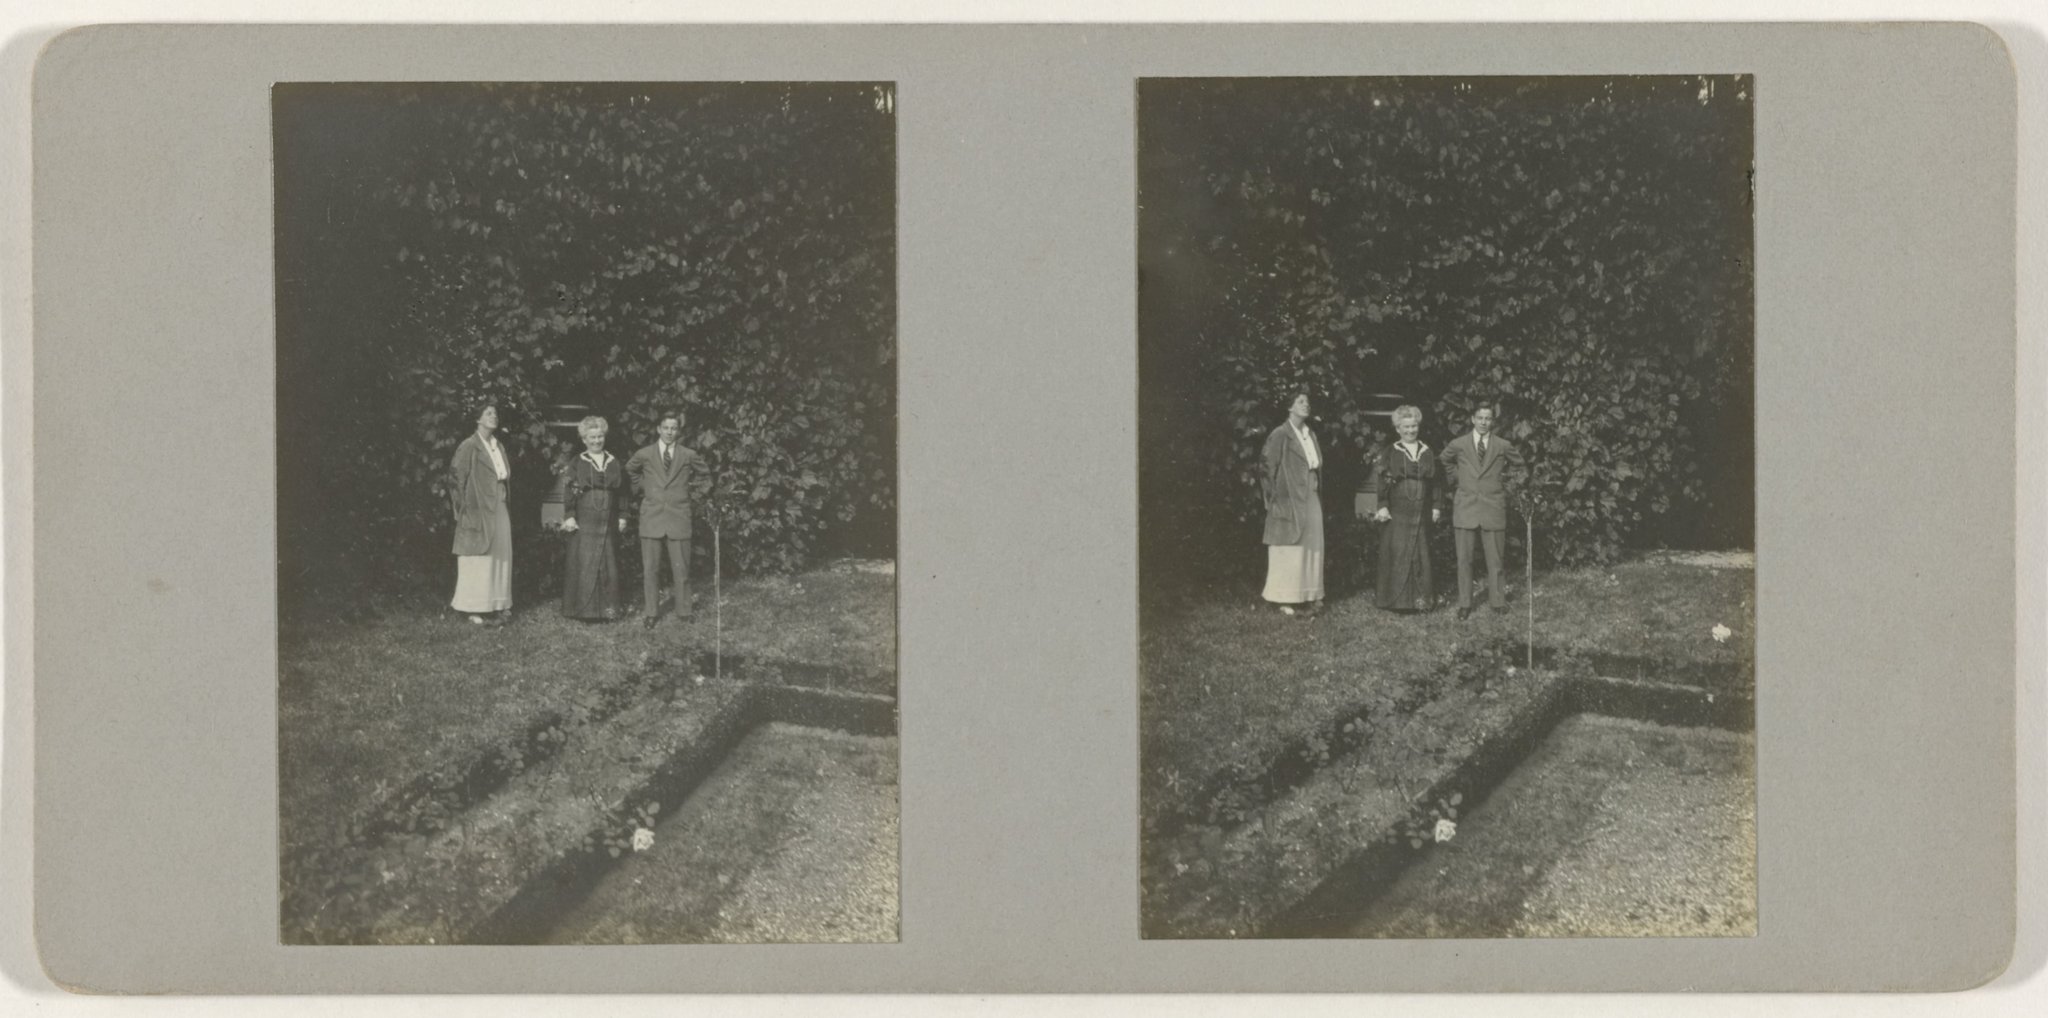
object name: stereograph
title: Margo Kessler-de Lange met Dolph en Bep Stoop in de tuin van landgoed De Pauw in Wassenaar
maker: geldolph adriaan kessler (dolph)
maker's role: fotograaf, industrieel, voetballer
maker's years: 1884-1945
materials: paper, photographic support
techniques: gelatin silver print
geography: wassenaar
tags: huize de paauw